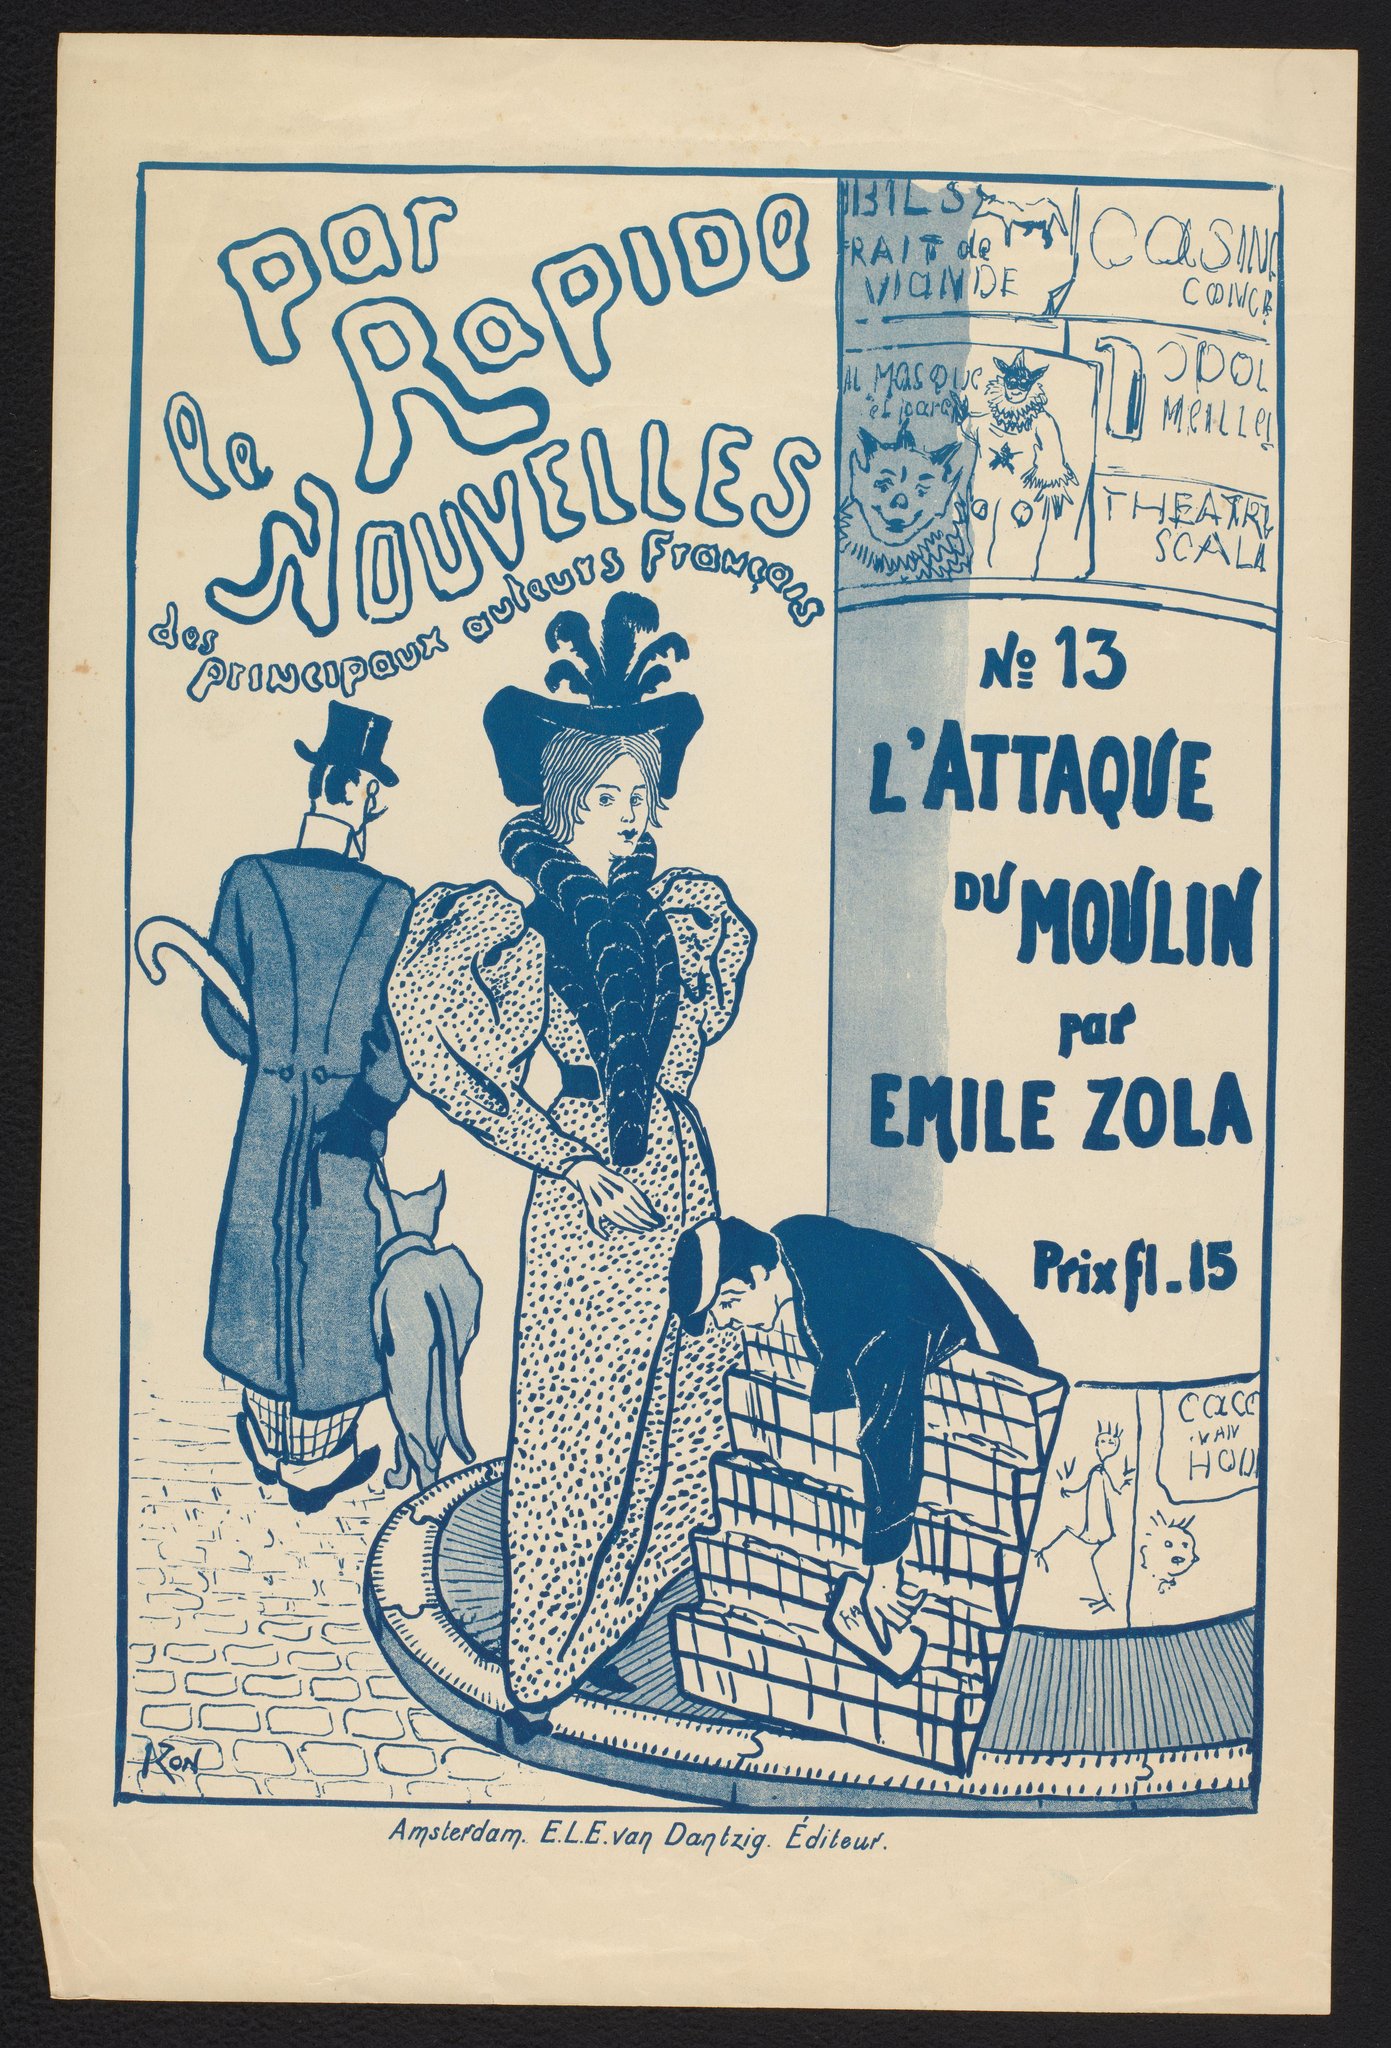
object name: print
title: Reclamebiljet voor een uitgave van 'l'Attaque du moulin' door Émile Zola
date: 1920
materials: paper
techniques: lithograph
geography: amsterdam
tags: emile zola, book-stall, kiosk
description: Reclambiljet ter promotie van het dertiende deel uit de reeks 'Par le rapide': Zola, Émile. L'Attaque du moulin. Amsterdam: E.L.E. van Dantzig, [ca. 1920].